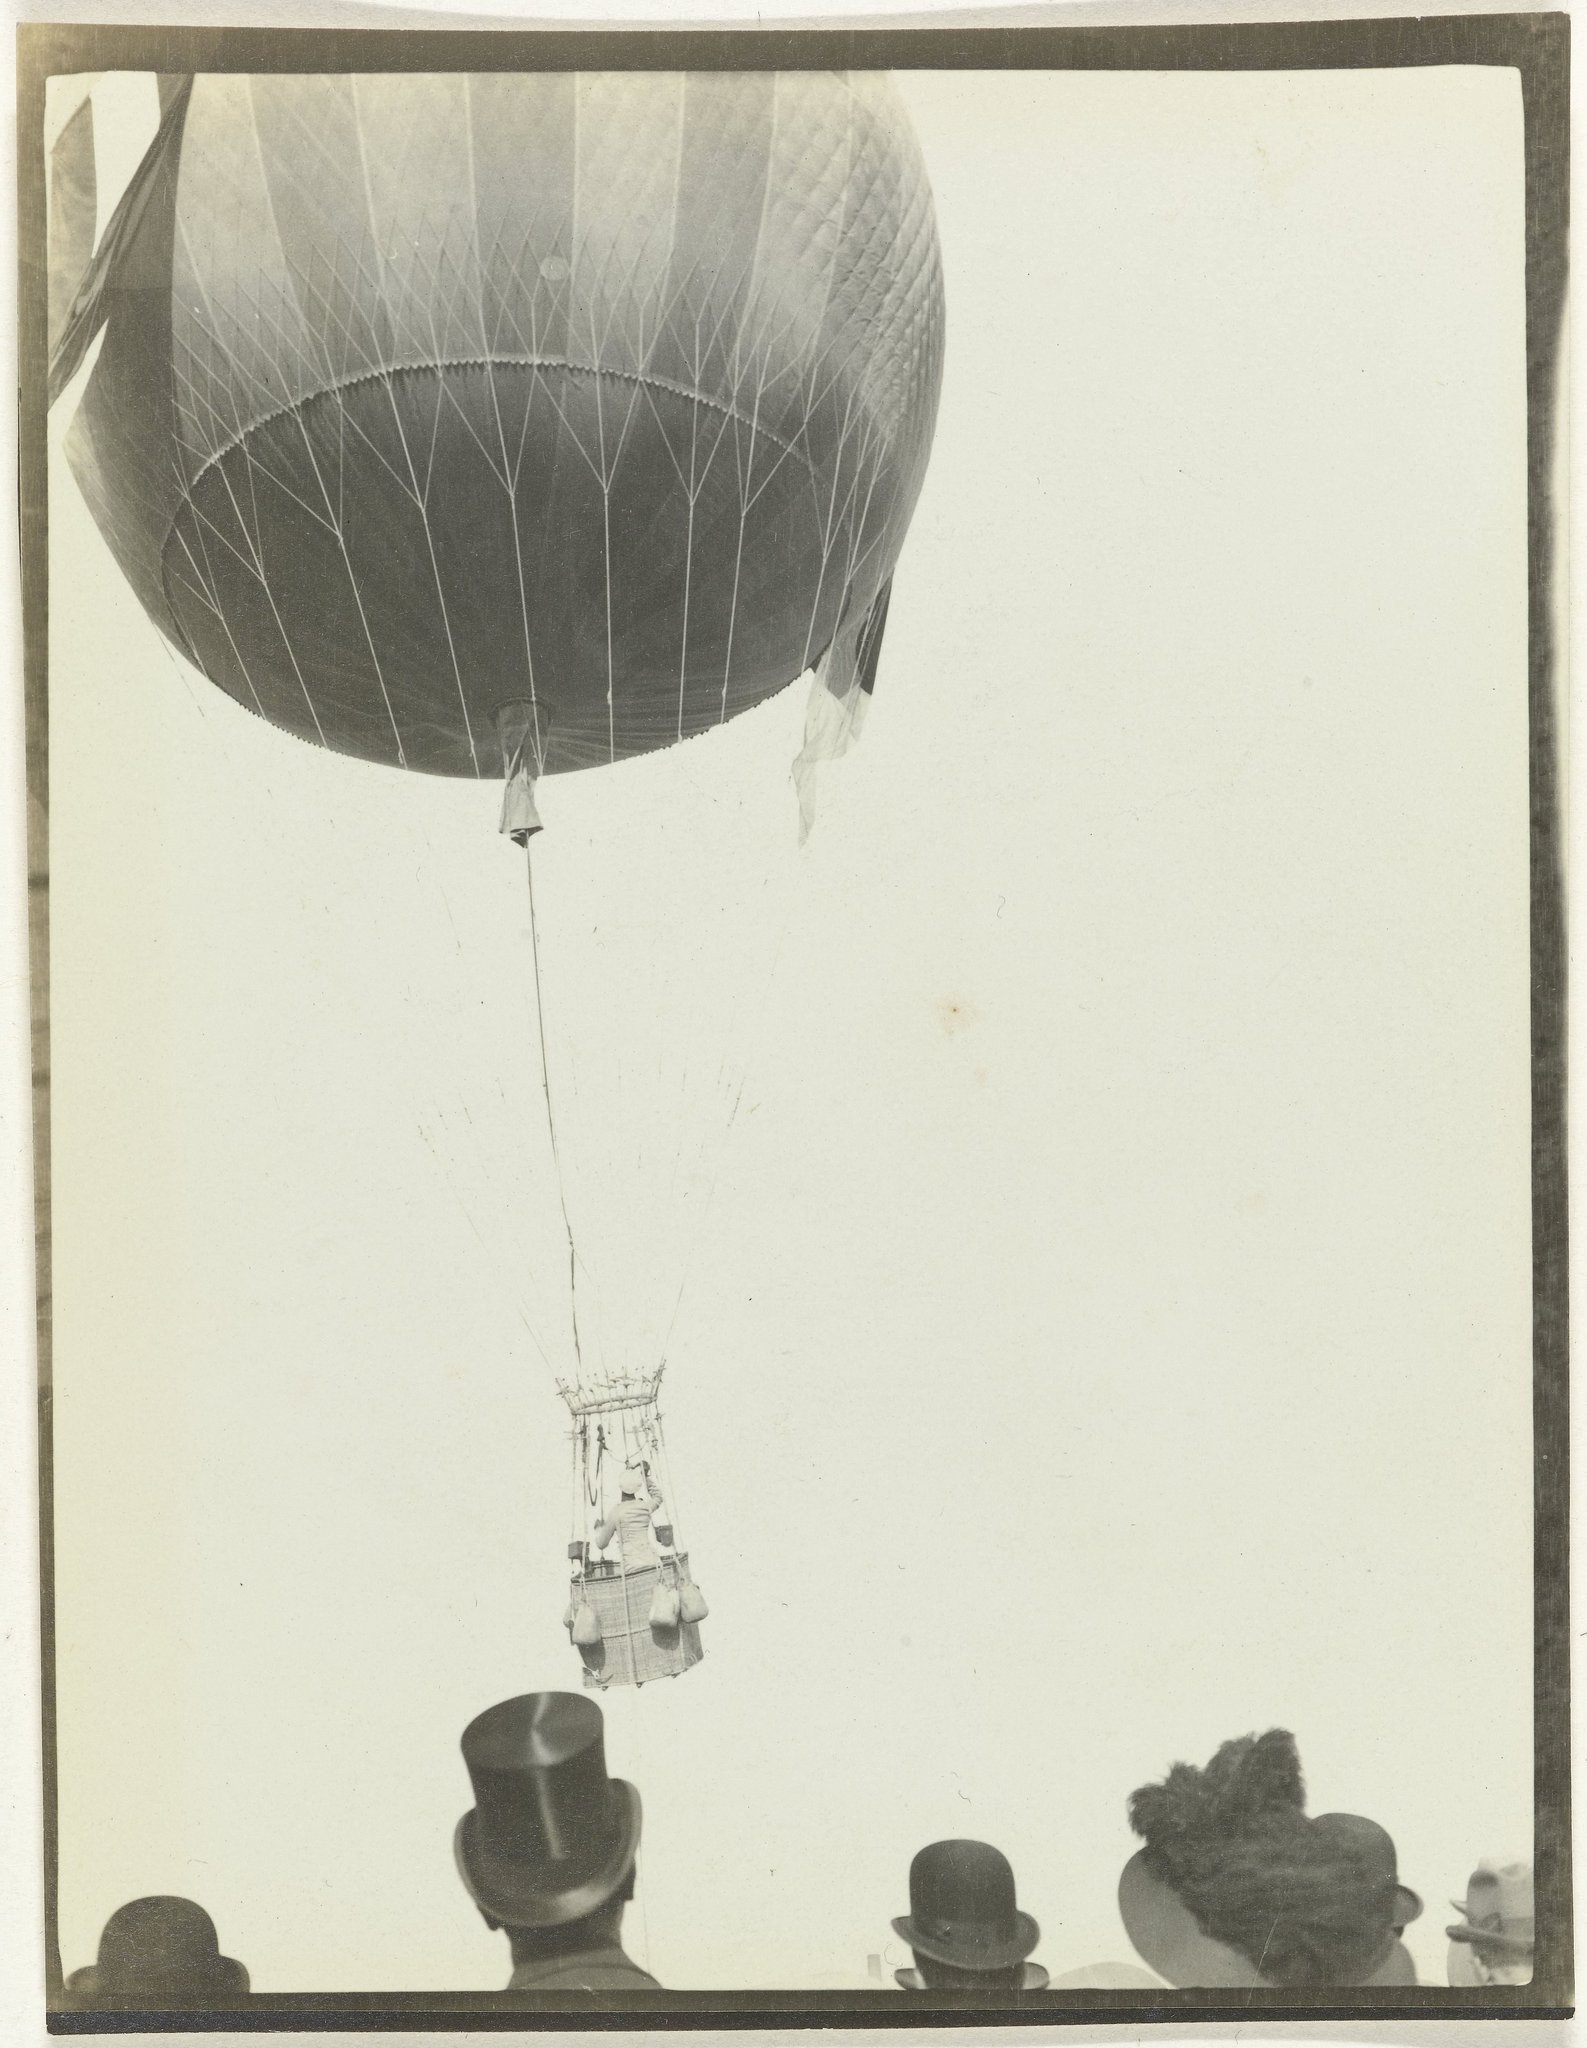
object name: photograph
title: The Third Gordon Bennett Balloon Race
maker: Anonymous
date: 1908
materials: paper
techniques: gelatin silver print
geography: schmargendorf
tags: (flying a) gas balloon, balloon flight (sport), balloon (aviation)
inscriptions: annotation: ‘"Ernst" Deutschland/ 37906/ 10/10/08/ Schmargendorf/ 10/10/08’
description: Opstijgende ballon met een man in de mand. Op de voorgrond hoofden van toeschouwers.